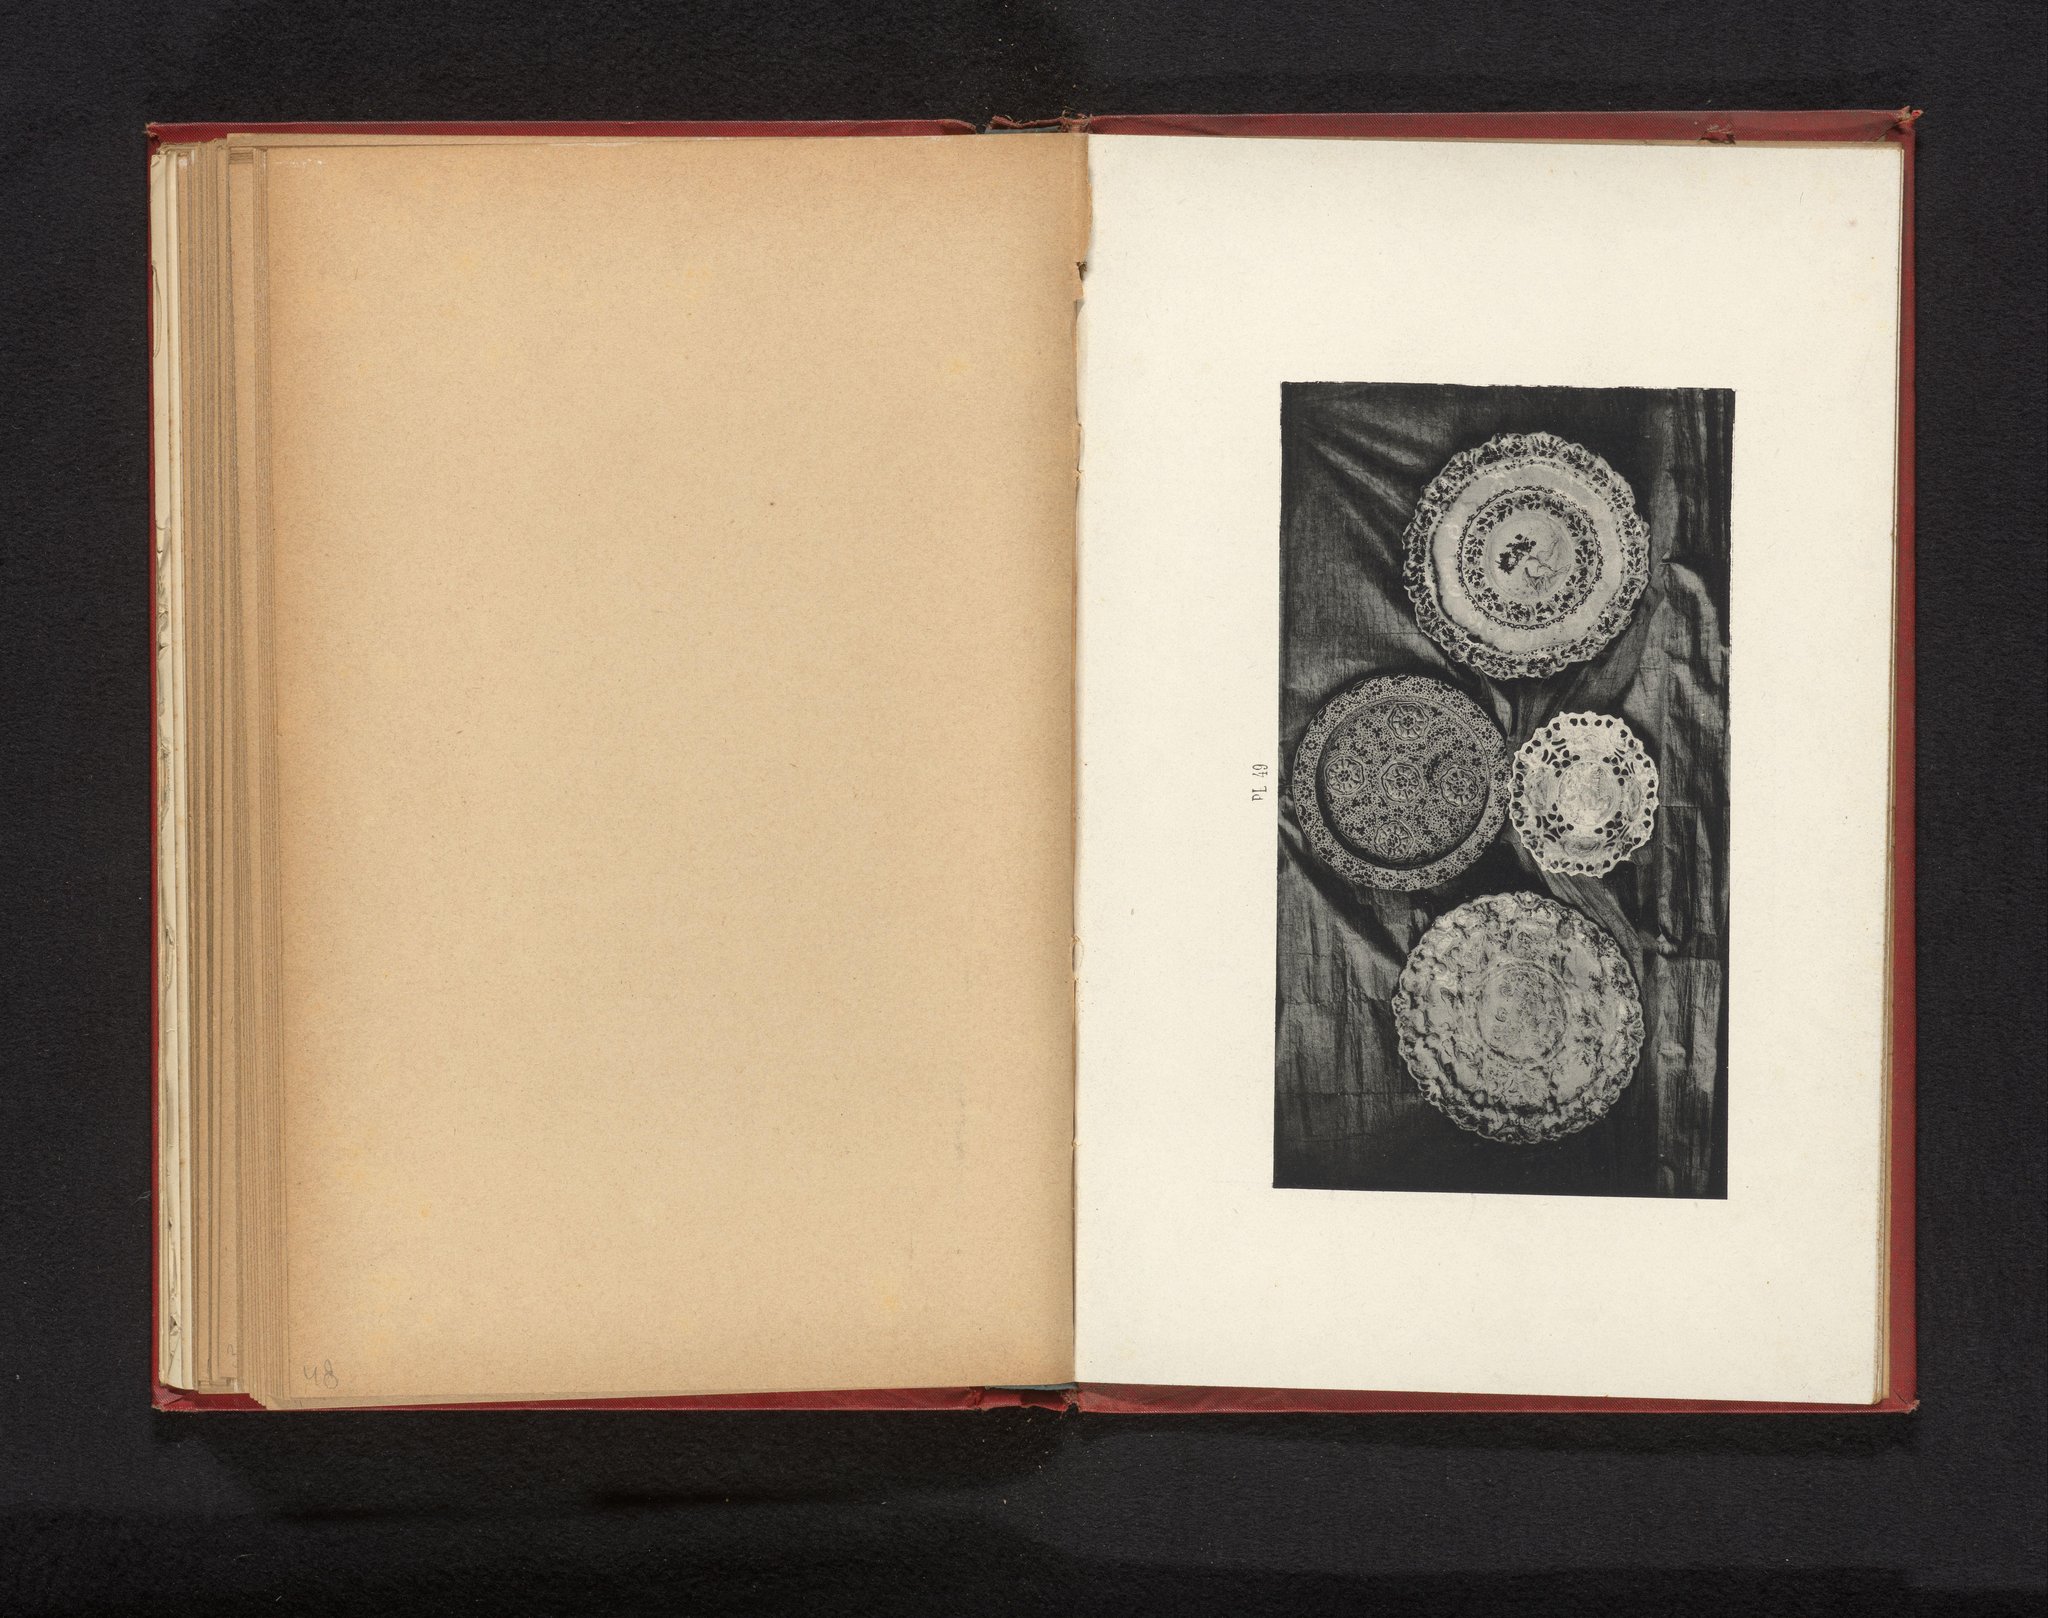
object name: page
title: Opstelling van vier (vermoedelijk) porseleinen borden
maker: Anonymous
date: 1880-1881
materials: paper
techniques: photograph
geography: barcelona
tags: dish, plate, saucer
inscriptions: number: ‘Pl 49’